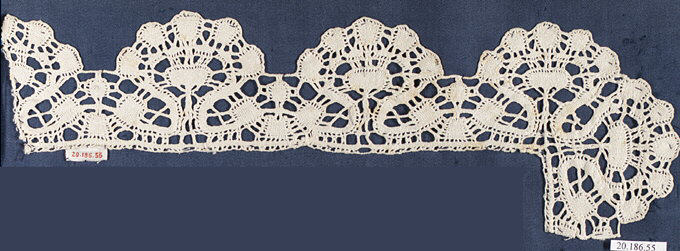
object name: piece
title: Corner piece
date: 1601-1700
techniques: lace